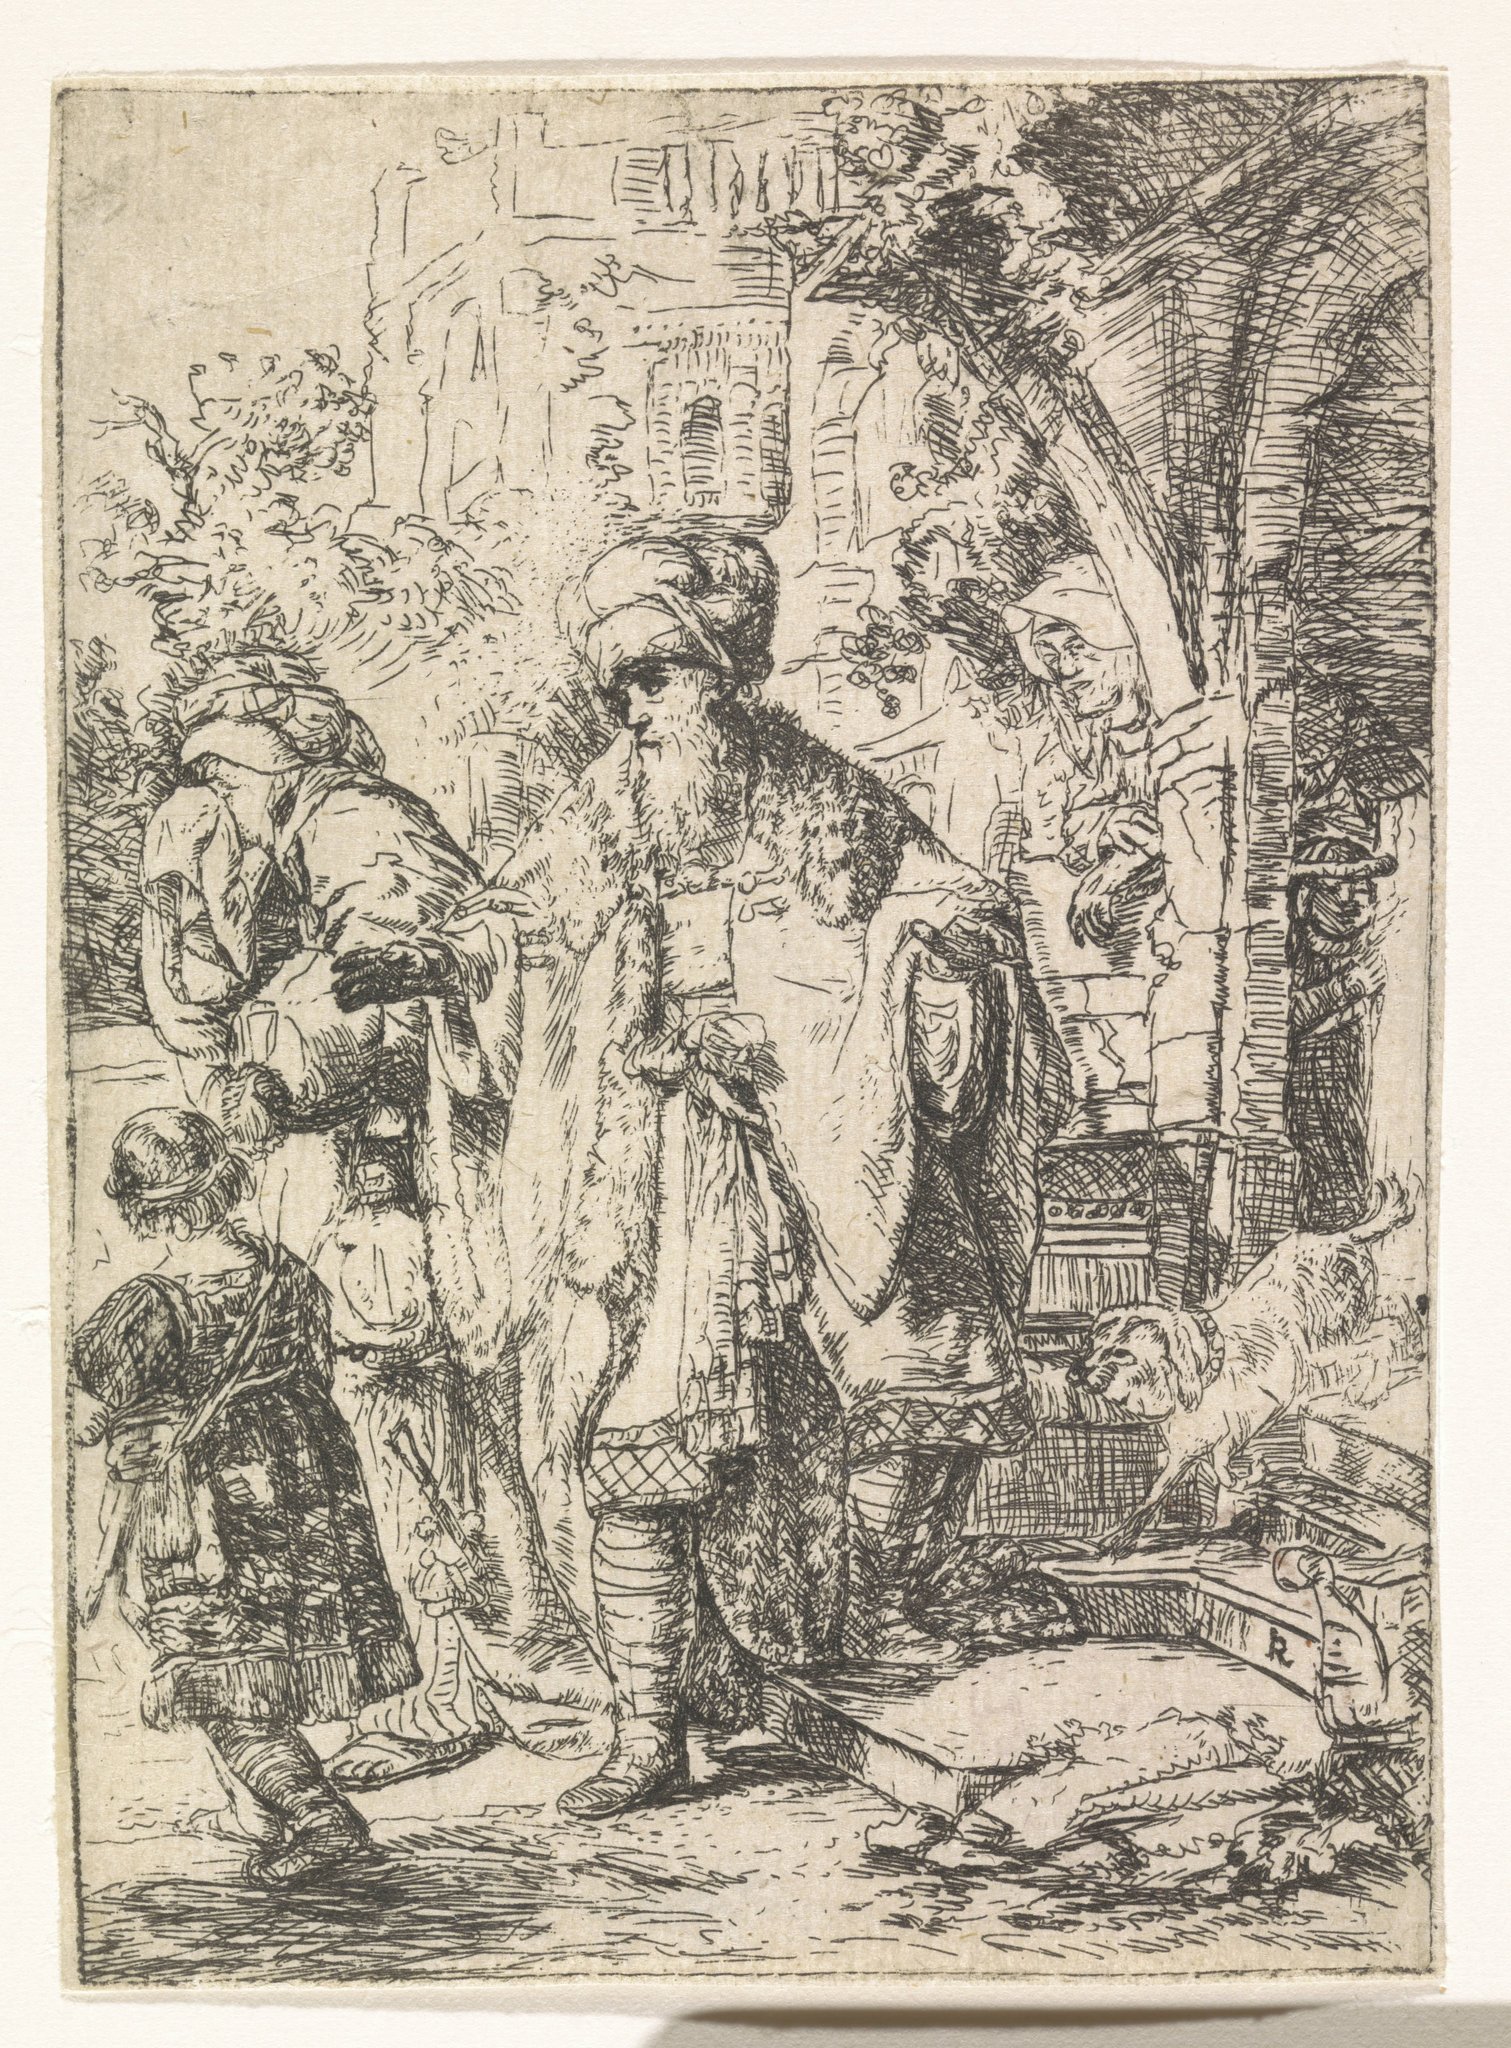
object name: print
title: Abraham verstoot Hagar en Ismaël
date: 1640-1660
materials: paper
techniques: etching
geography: amsterdam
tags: hagar and ishmael (often with bow and arrow) depart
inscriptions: collector's mark: Lugt 240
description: Abraham stuurt Hagar en Ismaël weg. Hagar houdt een zakdoek tegen haar gezicht. Sara kijkt toe uit het raam rechts, de kleine Isaak is zichtbaar in de deuropening. Op de drempel een hond.